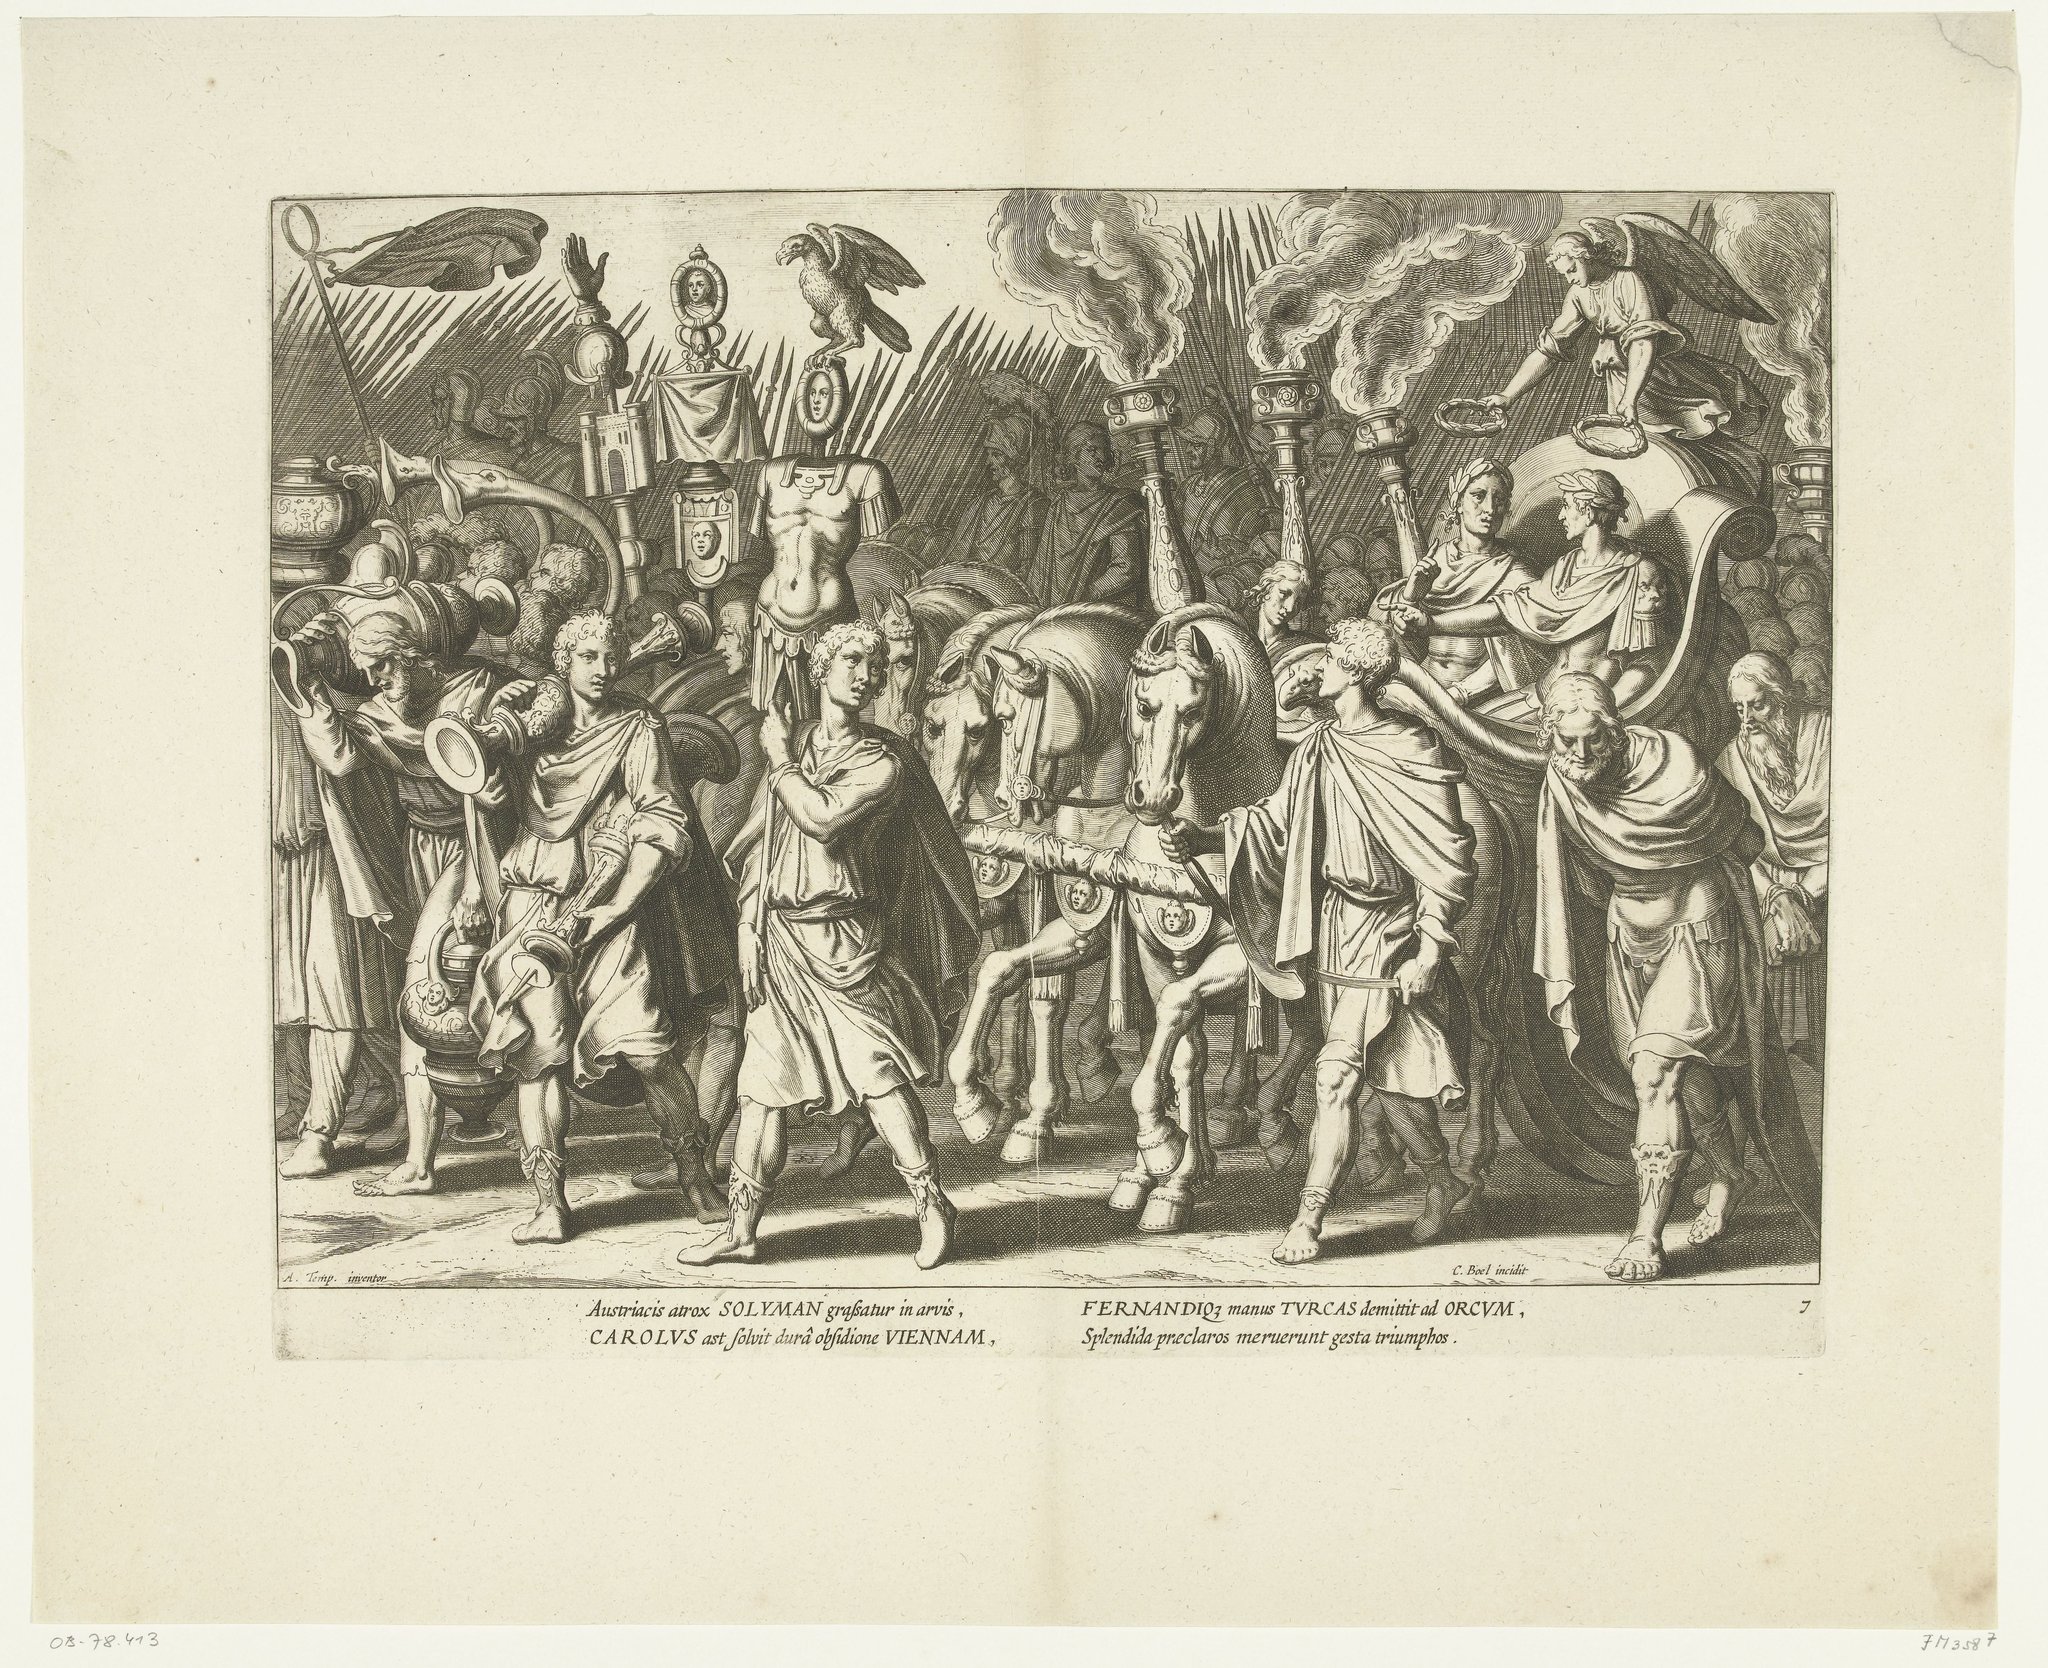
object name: history print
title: Zegetocht van keizer Karel V en zijn broer Ferdinand I naar de bevrijding van Wenen, nr. 7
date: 1614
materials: paper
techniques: engraving, etching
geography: northern netherlands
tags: ghent, charles v (holy roman emperor and king of spain), ferdinand i van habsburg (duits keizer), triumphal entry and public reception, pageant, 'entrée solennelle', 'joyeuse entrée', vienna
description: Optocht met Karel V en zijn broer Ferdinand I gezeten in een triomfwagen getrokken door paarden. Voorafgegaan door soldaten met standaarden en buit en hoornblazersAchter de zegewagen fakkeldragers. Rechts en op de achtergrond geboeide gevangenen, ca. 1532. Met onderschrift van vier regels in het Latijn.